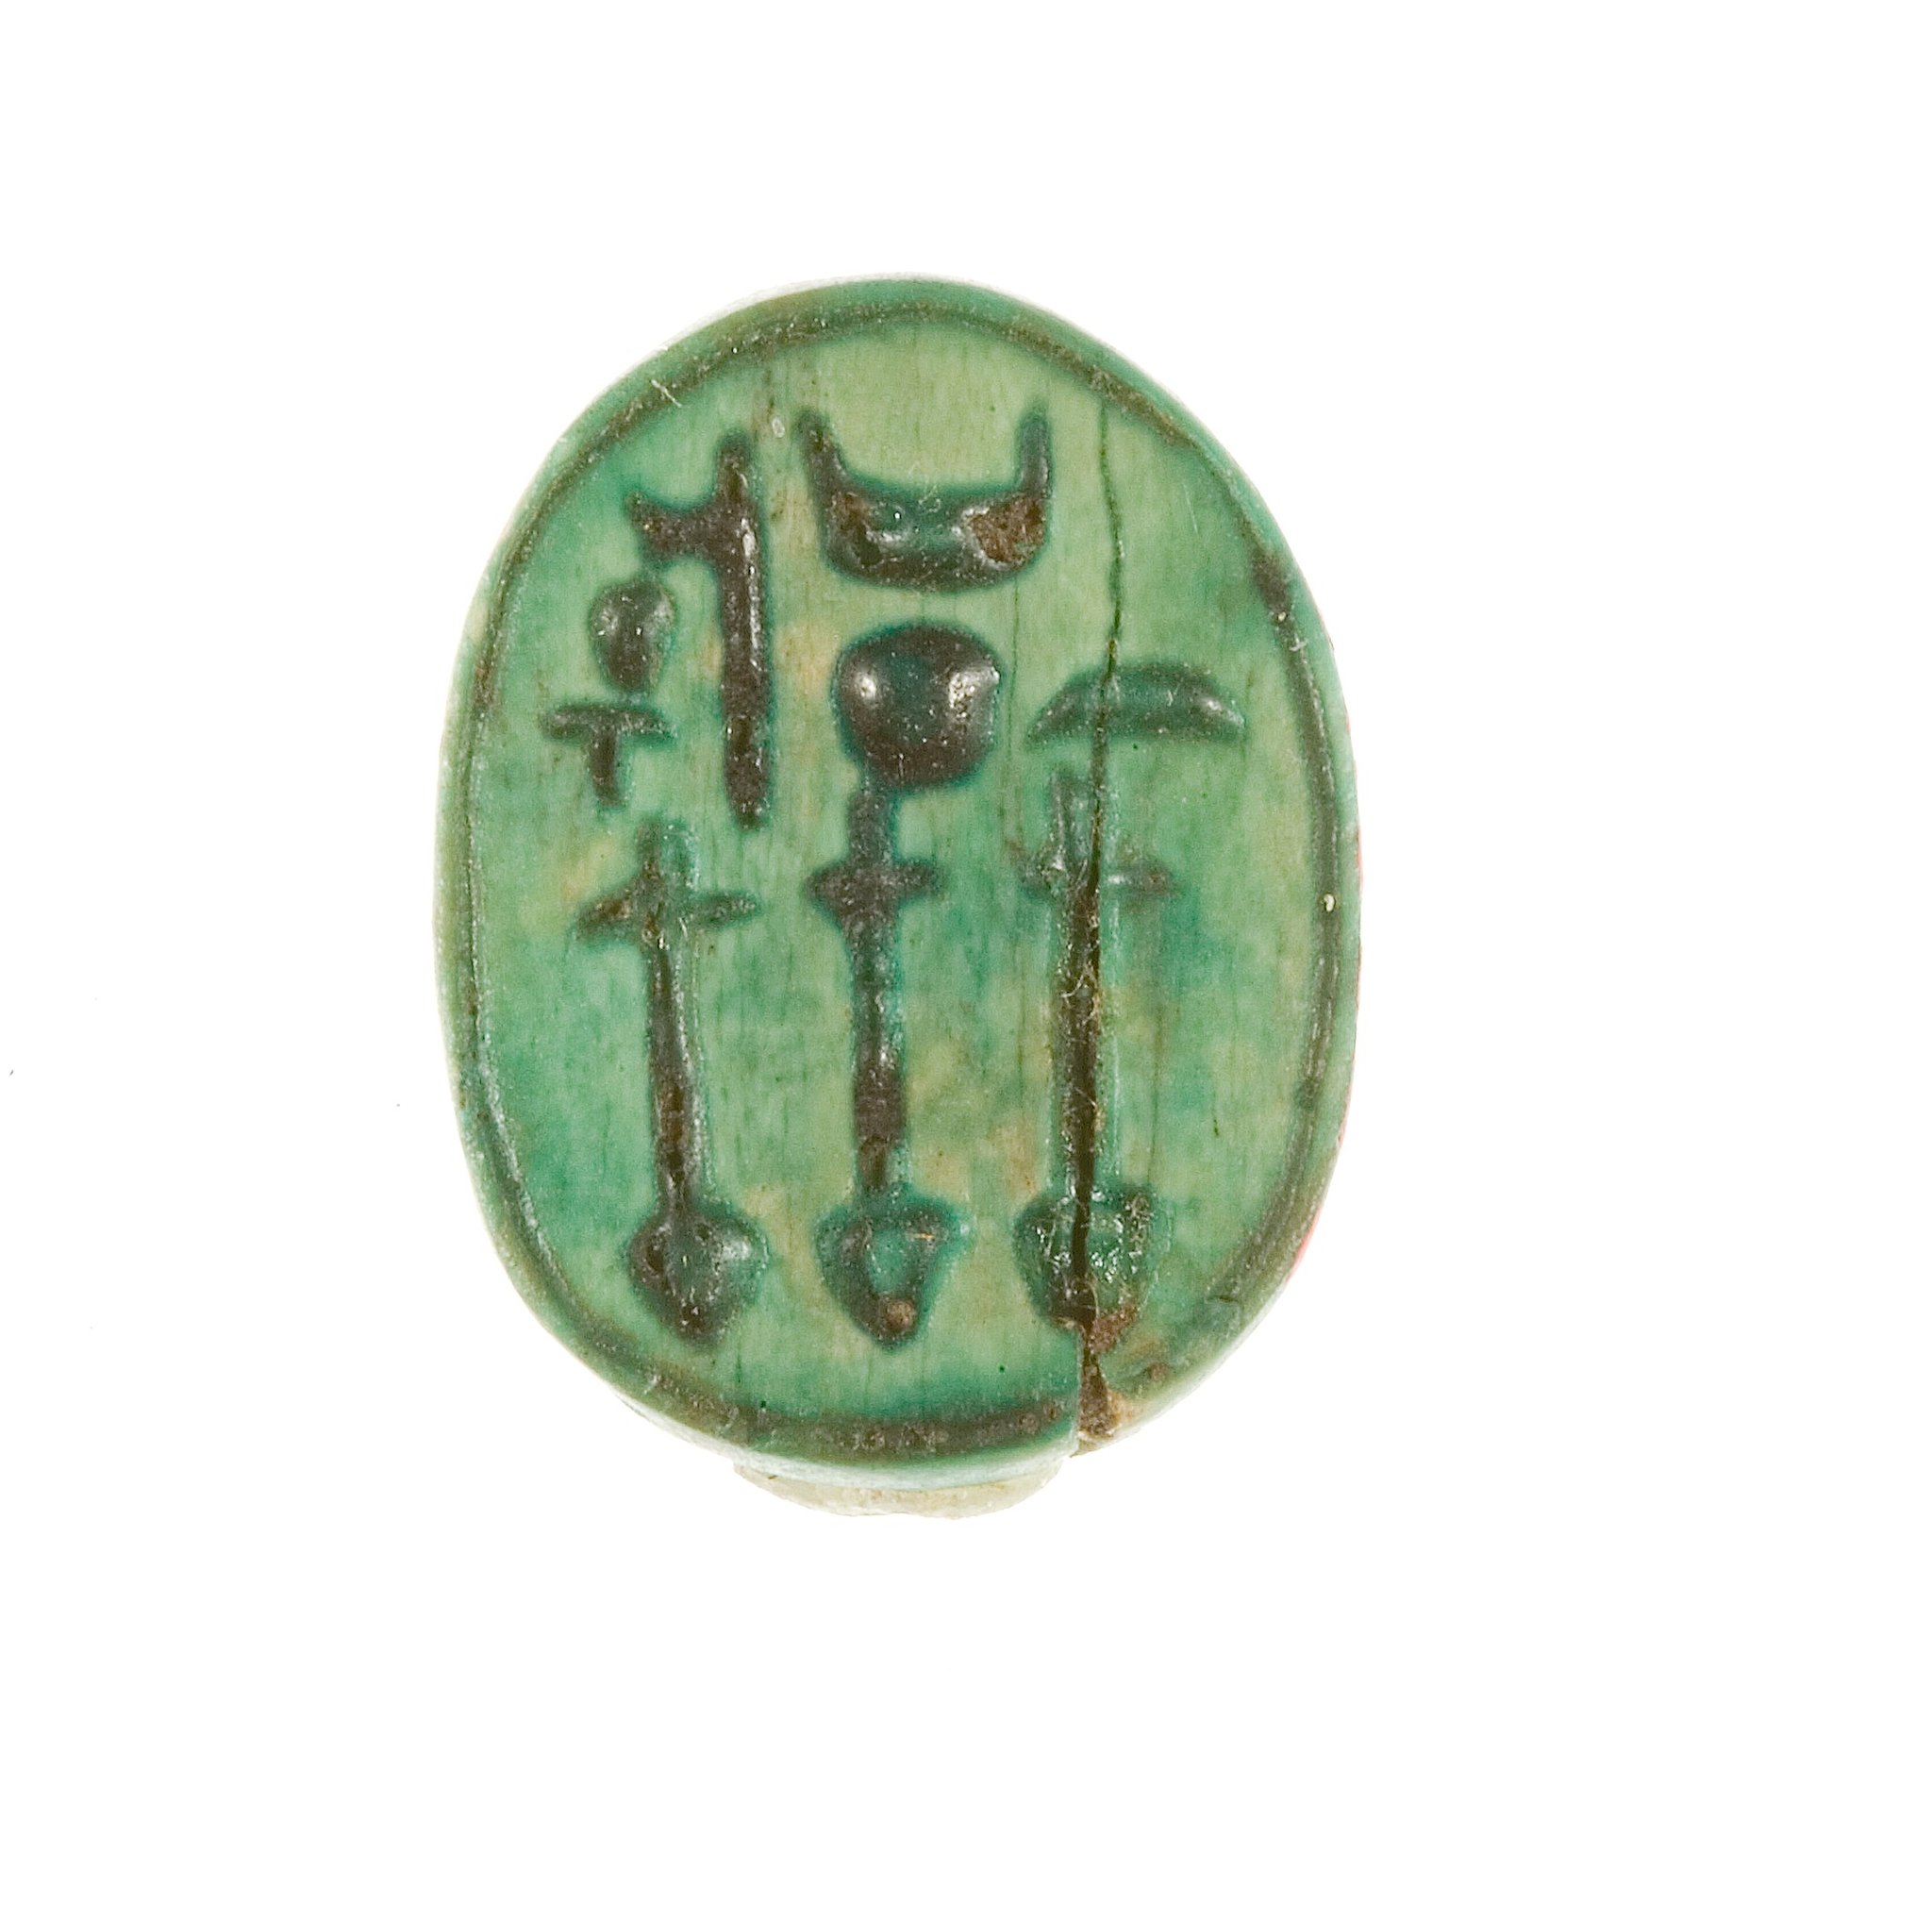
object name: scarab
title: Scarabs Inscribed for the God's Wife Neferure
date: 1479-1458 BCE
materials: stone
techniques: glazing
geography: egypt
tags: hieroglyphs,scarabs